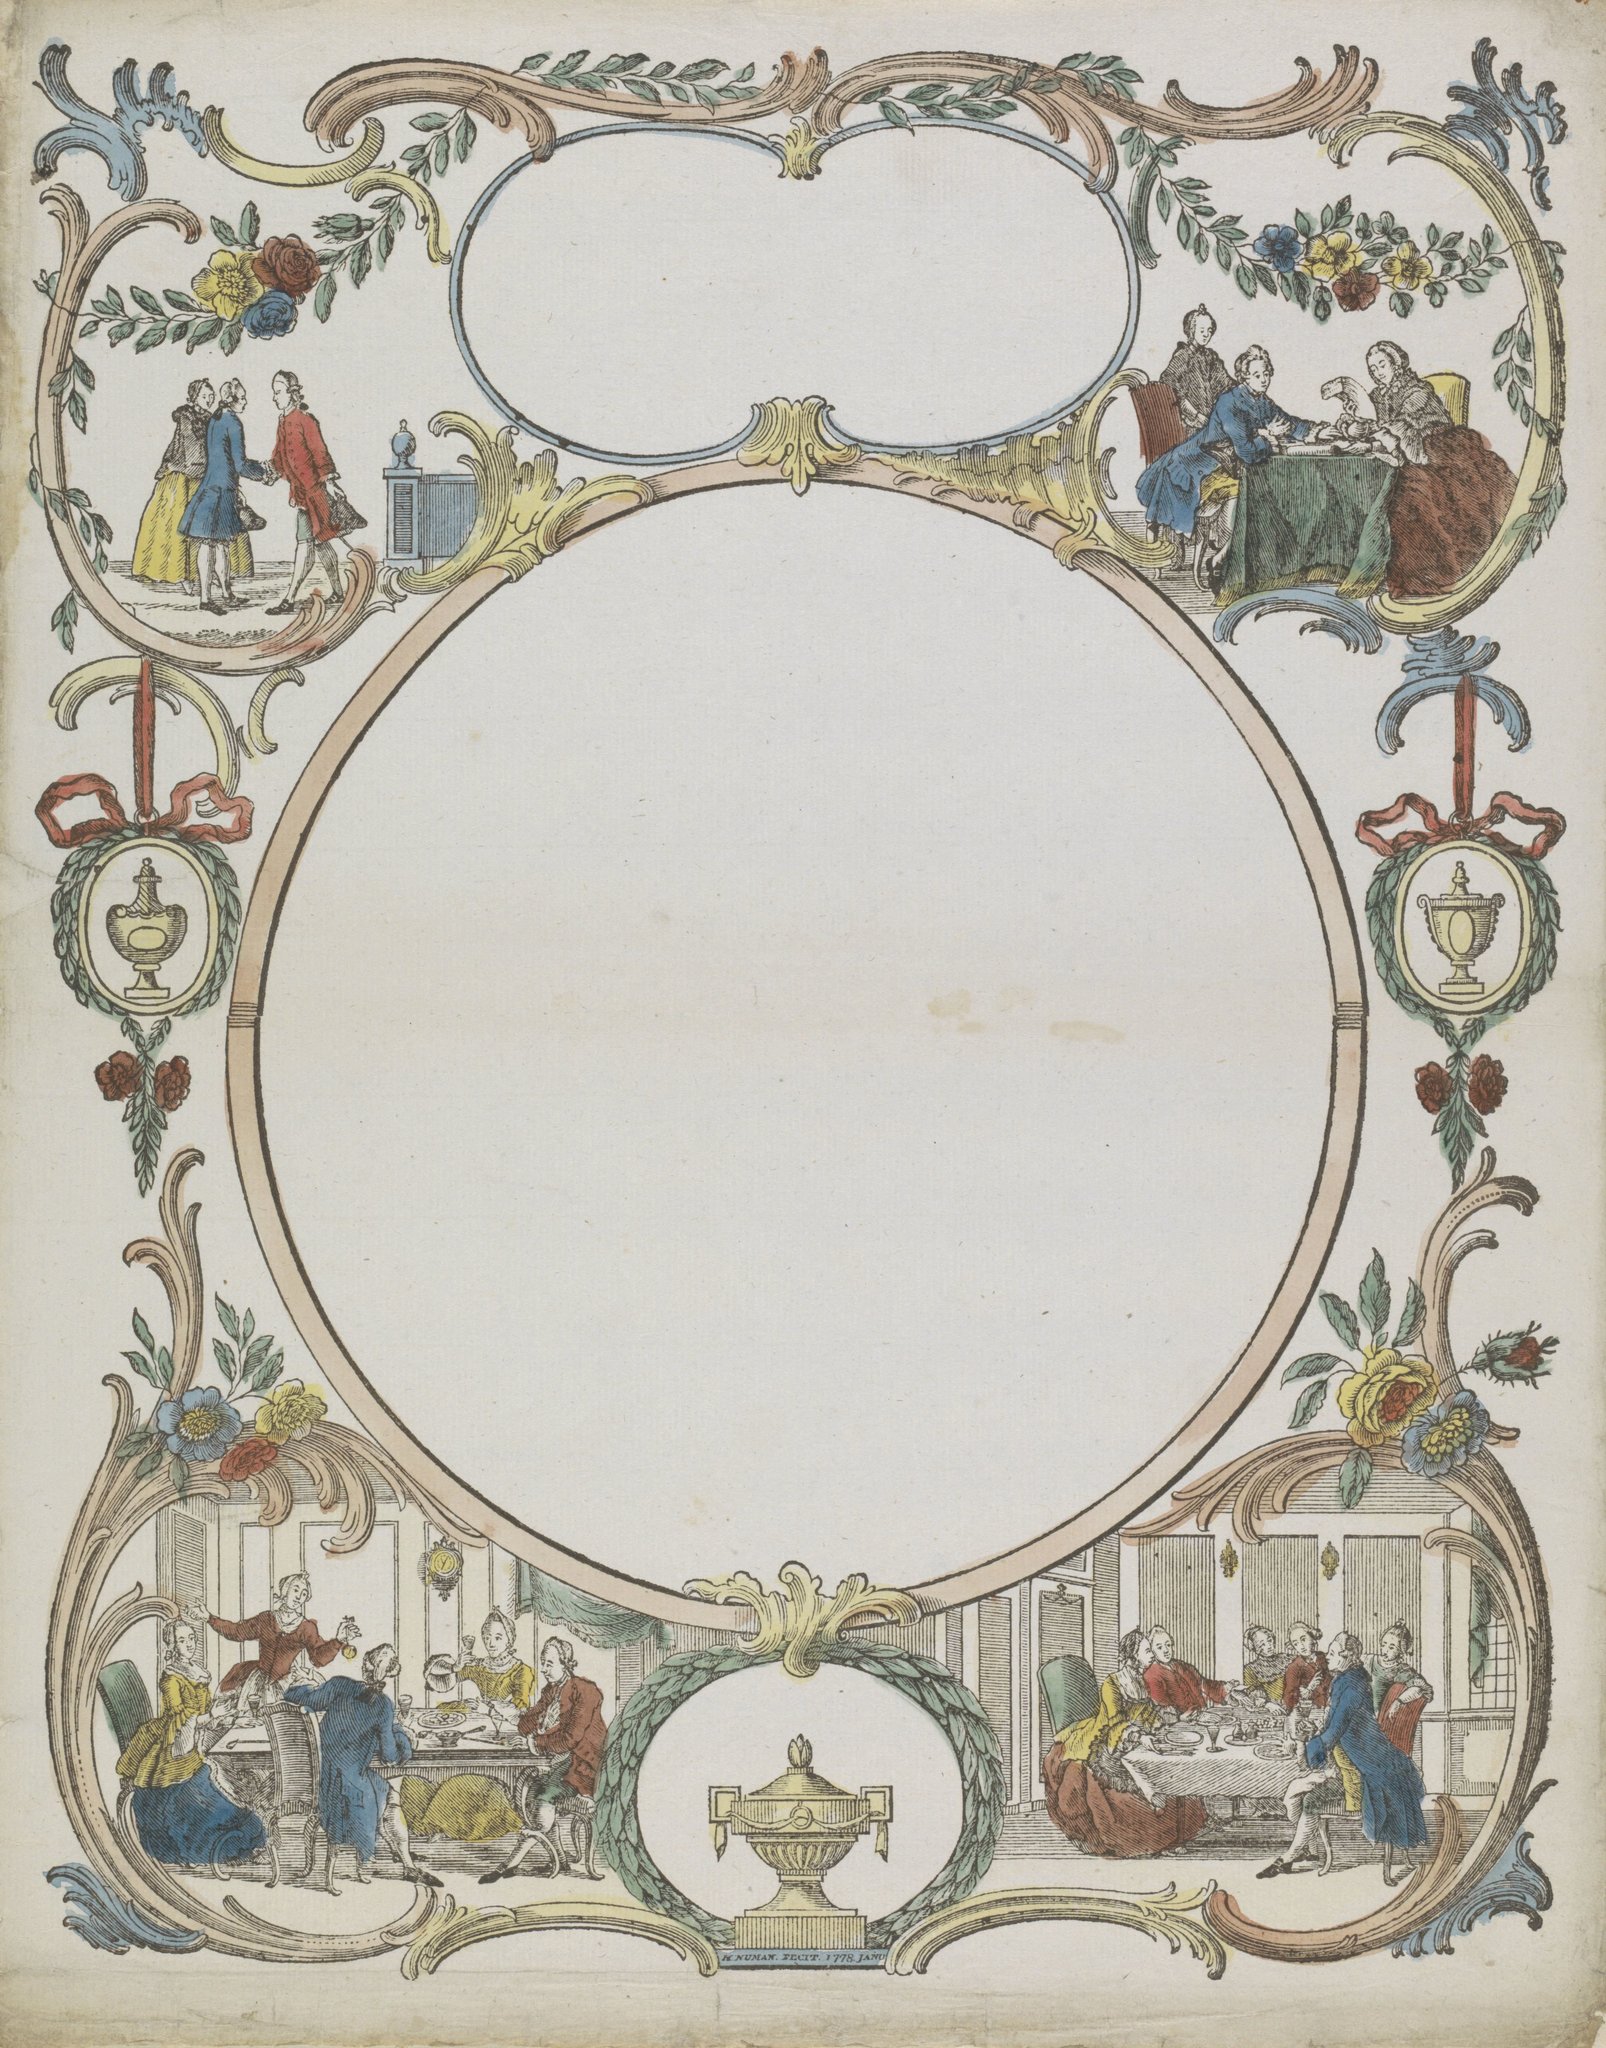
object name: popular print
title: Wensbrief met decoratief kader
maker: Anonymous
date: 1778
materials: paper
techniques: colour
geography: netherlands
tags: shaking hands, 'dextrarum junctio', evening meal, dinner, supper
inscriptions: collector's mark: Lugt 2760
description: Wensbrief met onbeschreven cartouche binnen een decoratief kader met voorstellingen van gezelschapen rond een tafel, en twee mannen die elkaar de hand schudden.